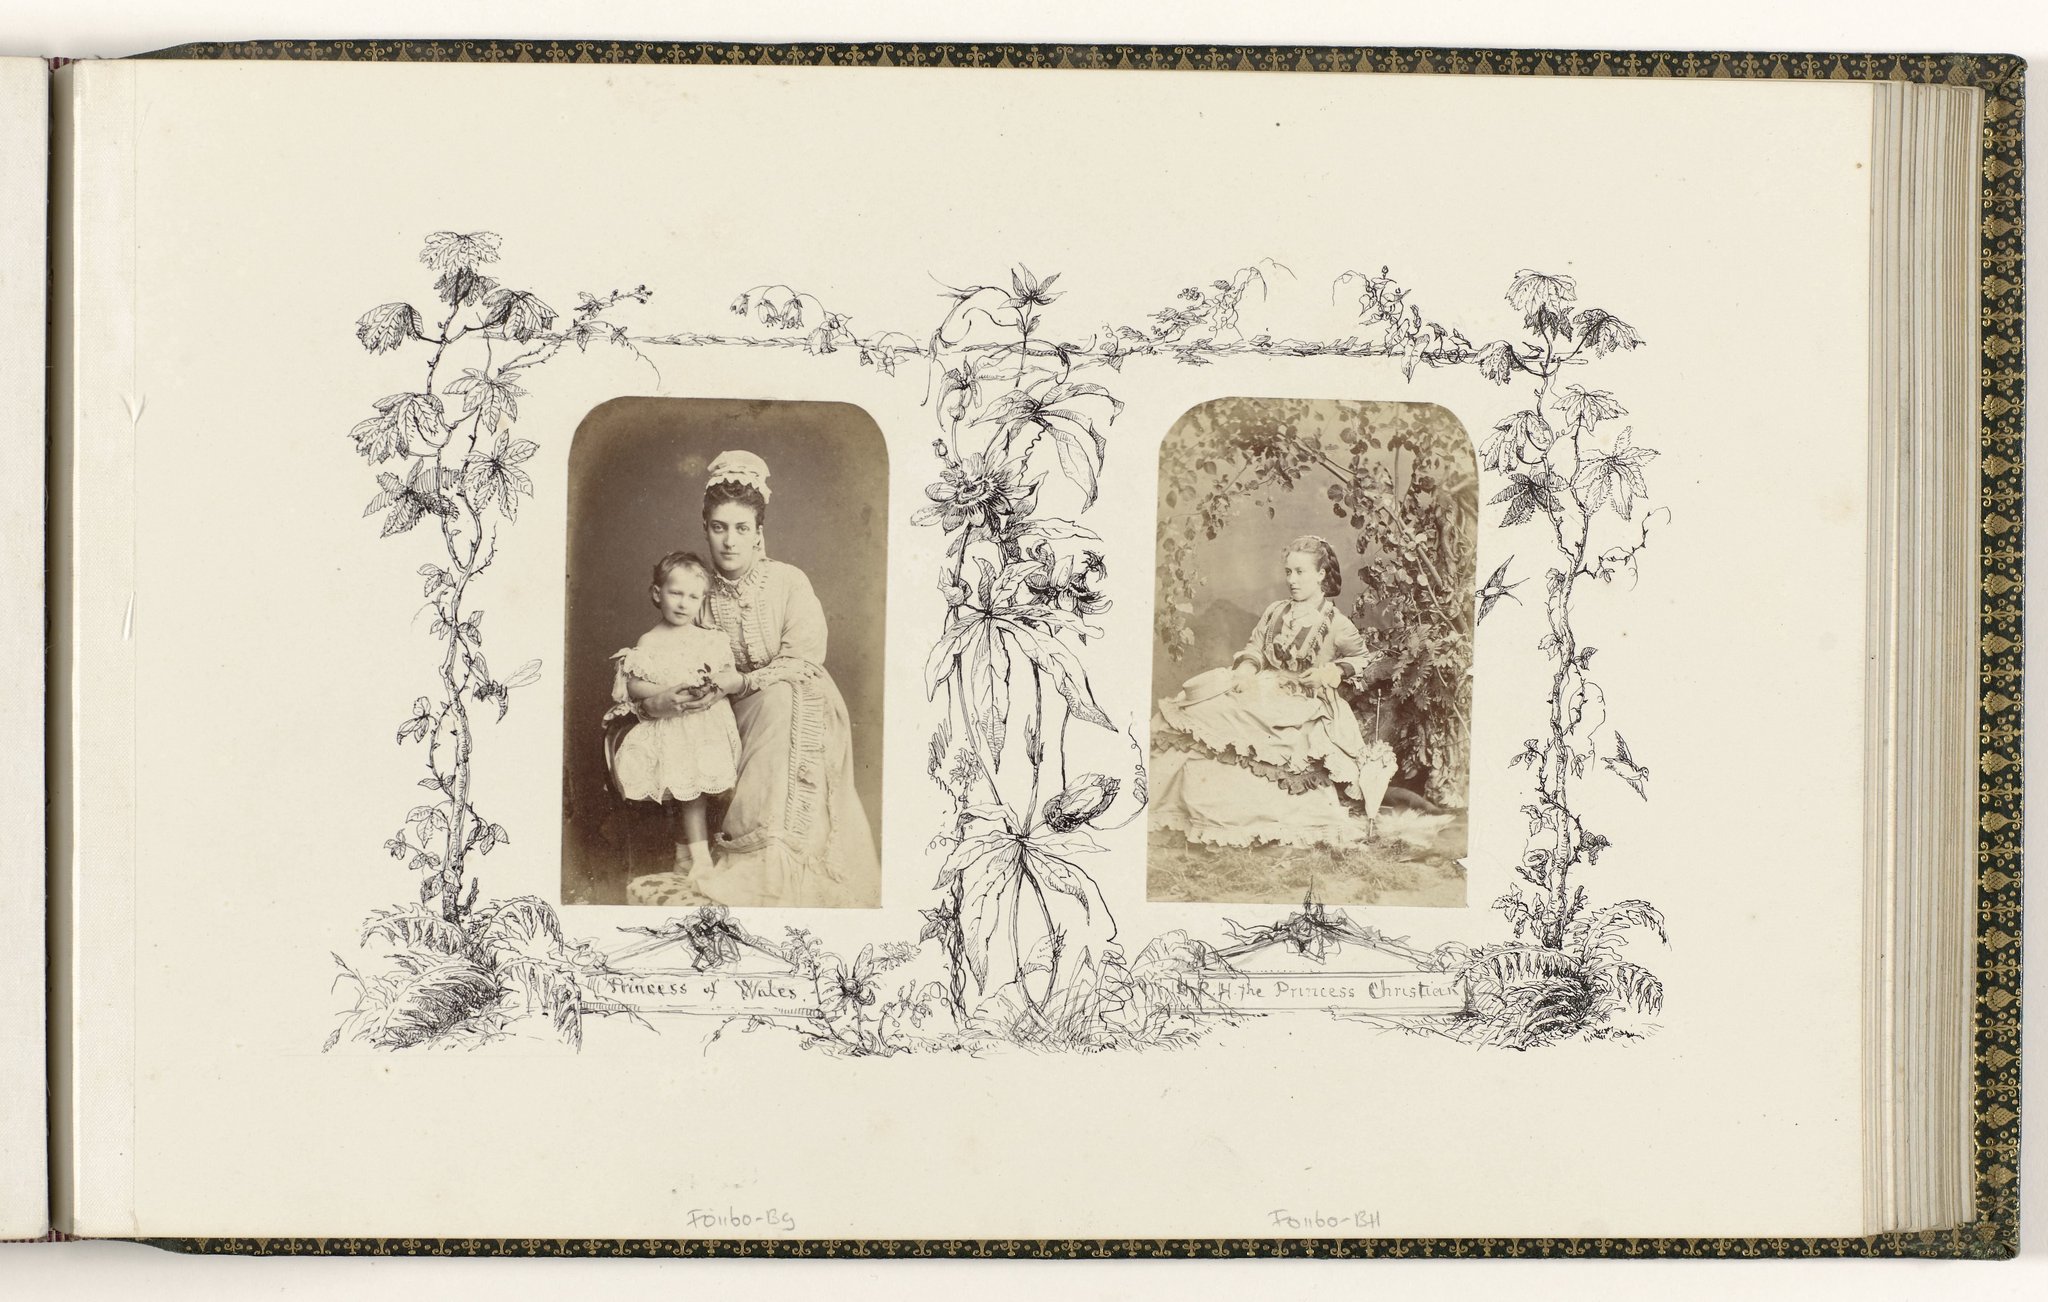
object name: photograph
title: Portret van prinses Christian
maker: Anonymous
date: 1870-1880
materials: paper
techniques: albumen print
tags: historical persons - bb - woman, princess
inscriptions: inscription: ‘H.R.H. the Princess Christian’